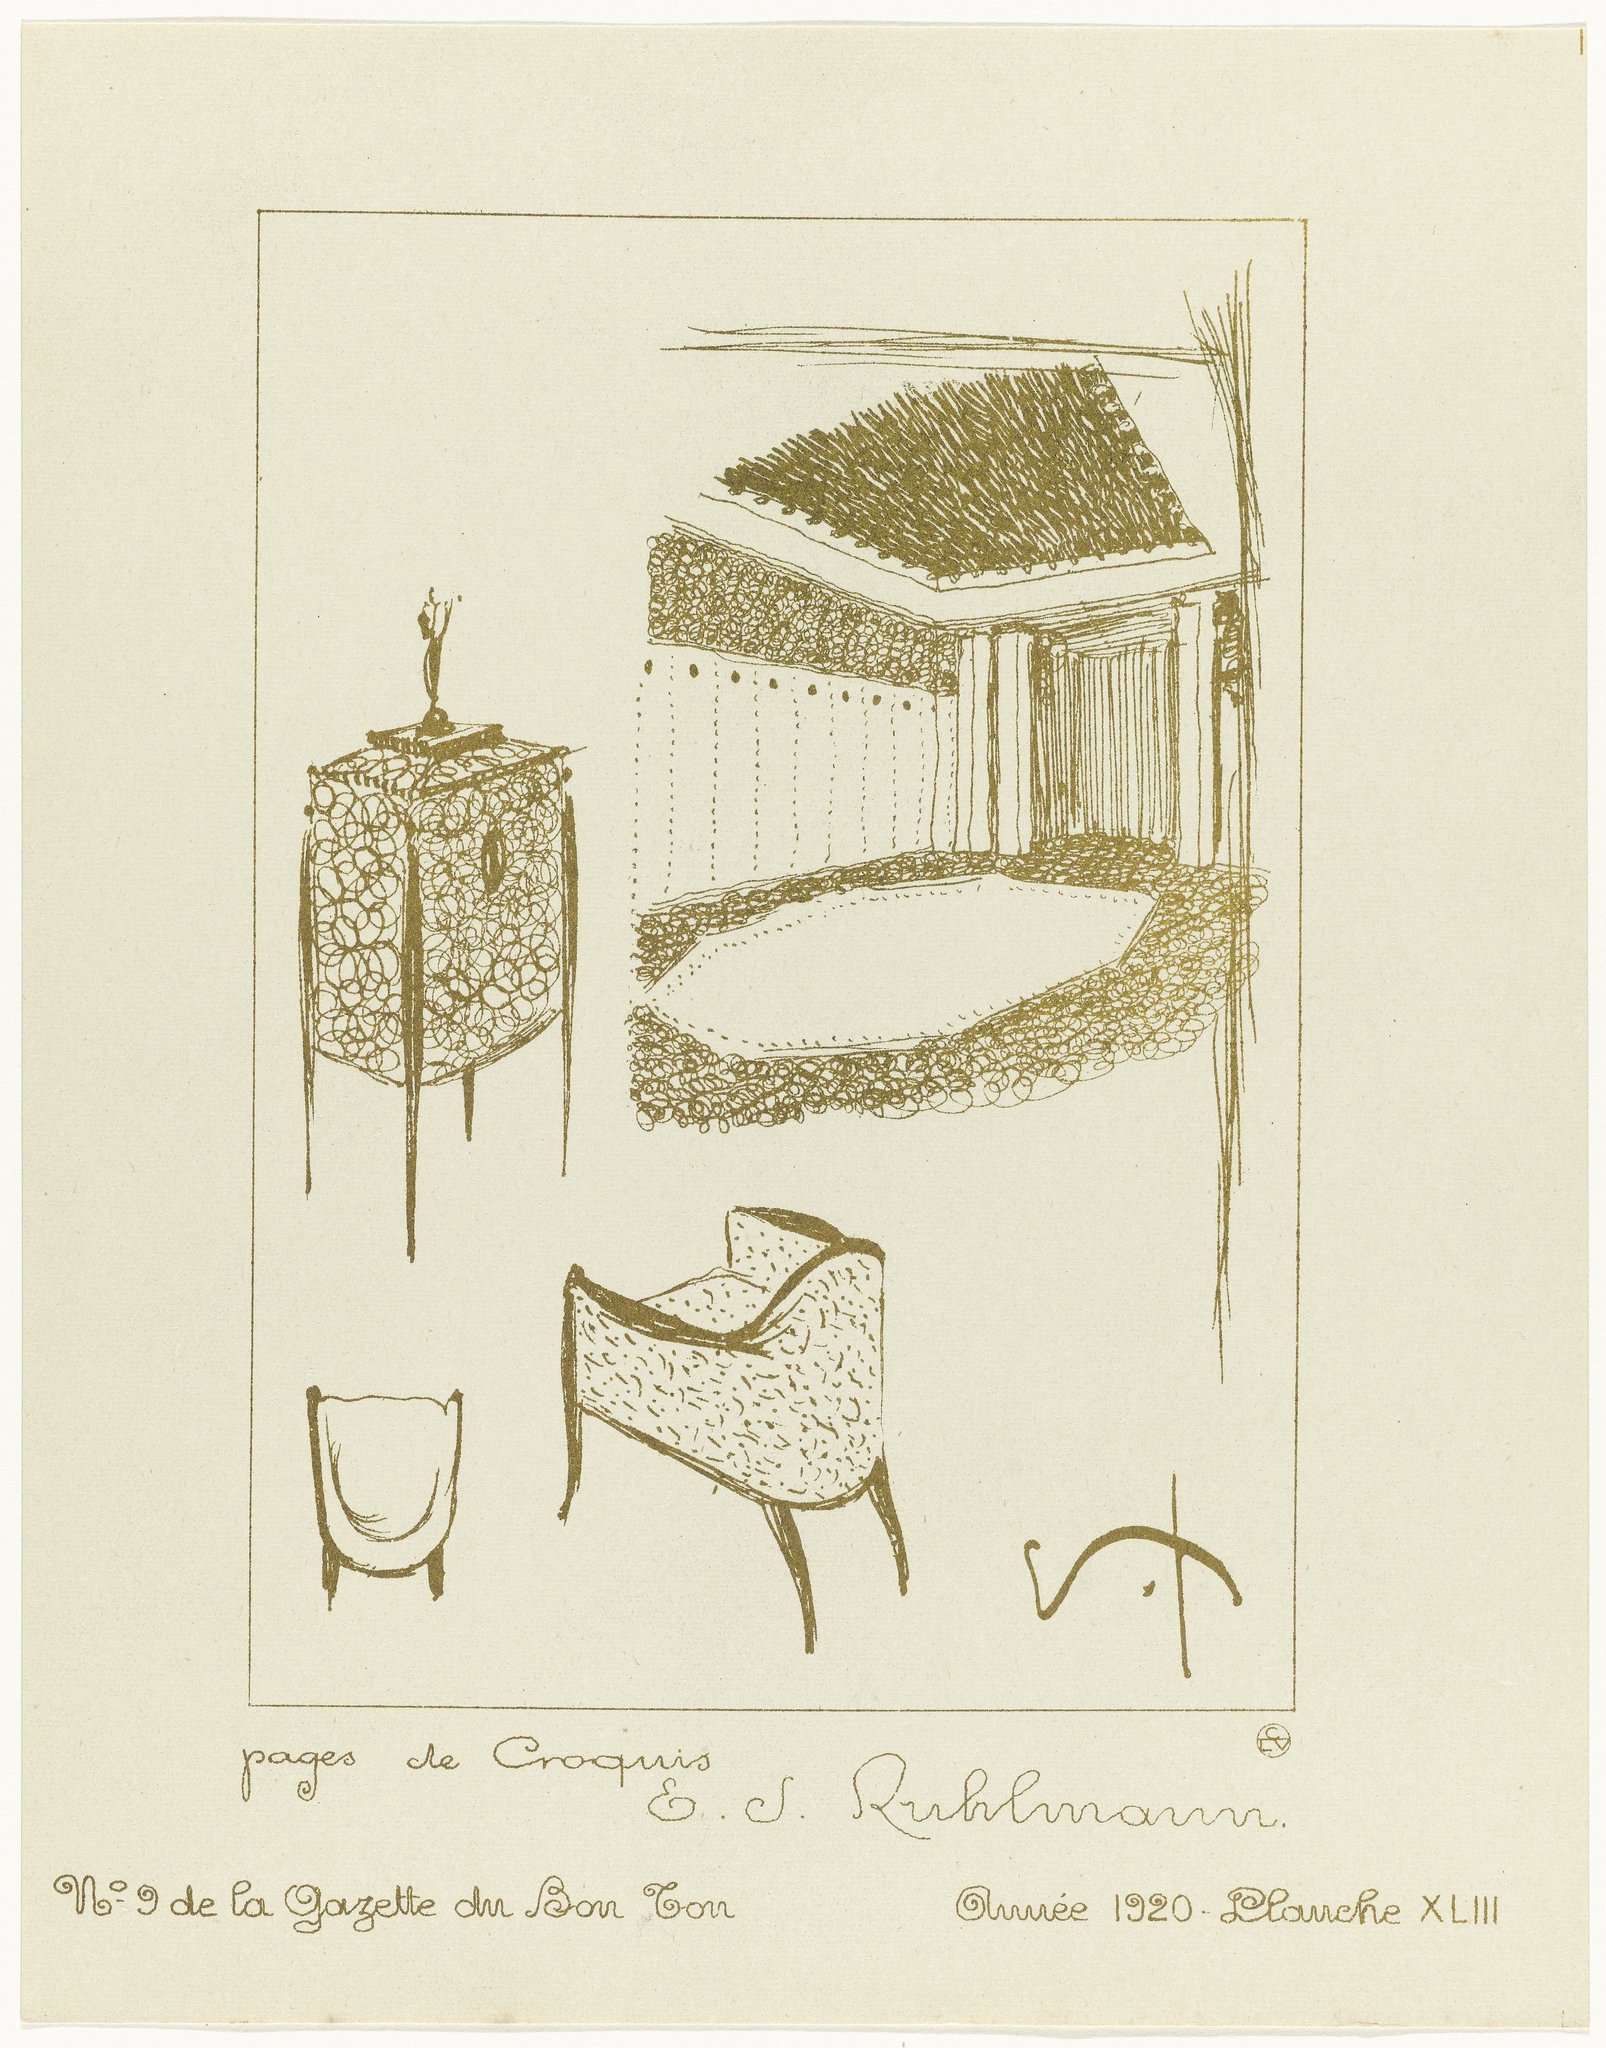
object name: fashion print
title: Gazette du Bon Ton, 1920 - No. 9, Pl. XLIII: Pages de croquis E.J. Ruhlmann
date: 1920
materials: paper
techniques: lithograph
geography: geneva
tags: fashion plates, furniture and household effects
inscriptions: date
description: Schetsen van een stoel en ander meubilair door Émile-Jacques Ruhlmann. Planche XLIII uit Gazette du Bon Ton 1920, No. 9. Uitleg over de badkamer op pagina "Explication des Planches".